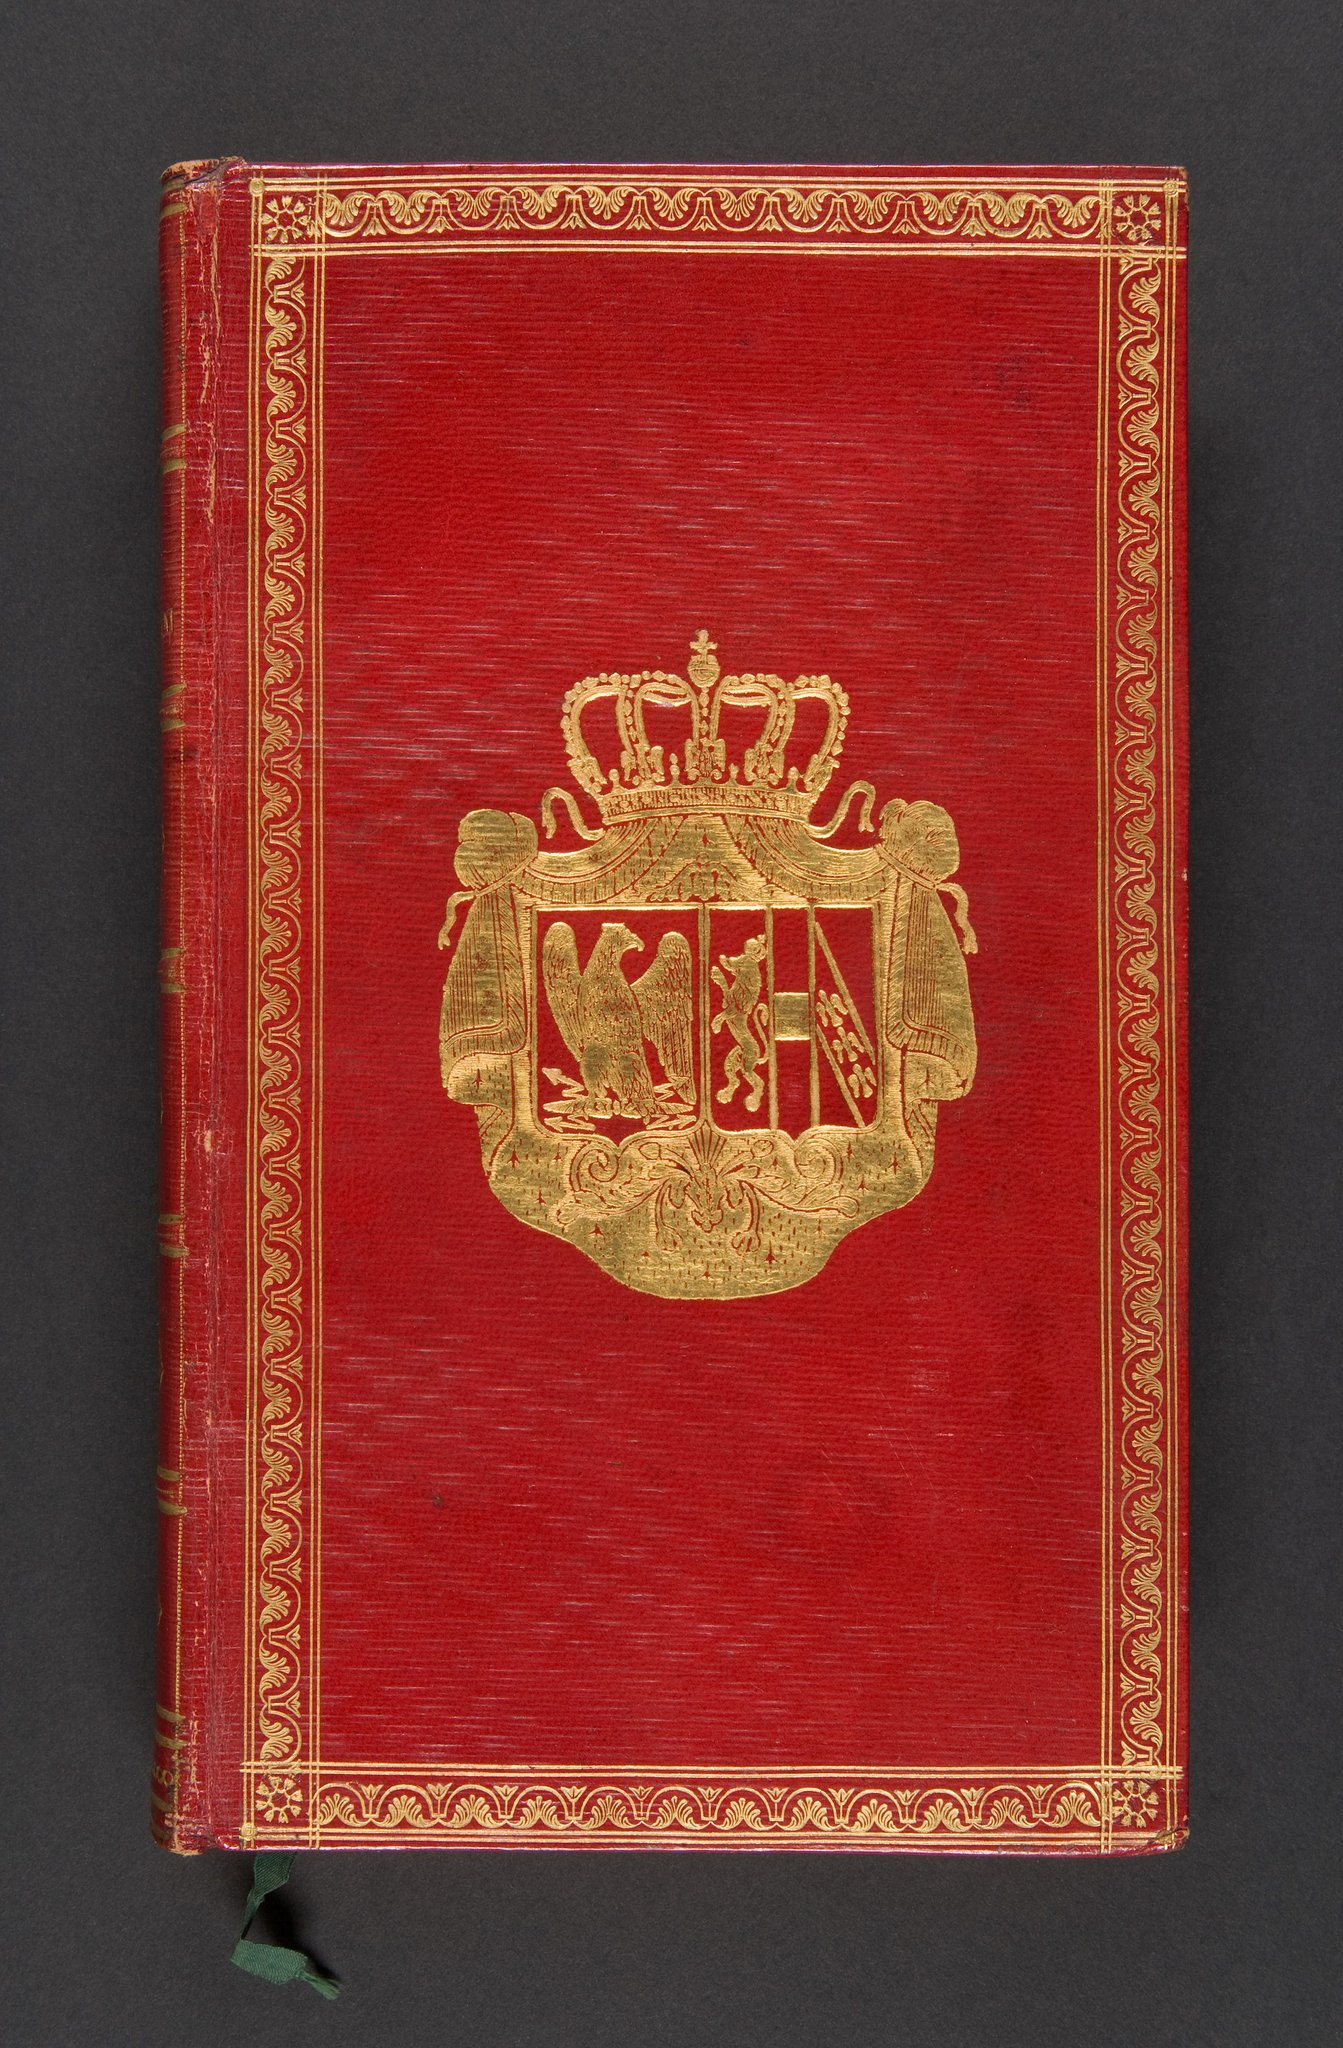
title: Galerie Giustiniani, ou, Catalogue figuré des tableaux de cette célèbre galerie, transportée d'Italie en France, accompagné d'observations critiques et historiques, et de soixante-douze planches gravée au trait, contenant environ cent cinquante sujets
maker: charles-paul landon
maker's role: editor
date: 1812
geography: france